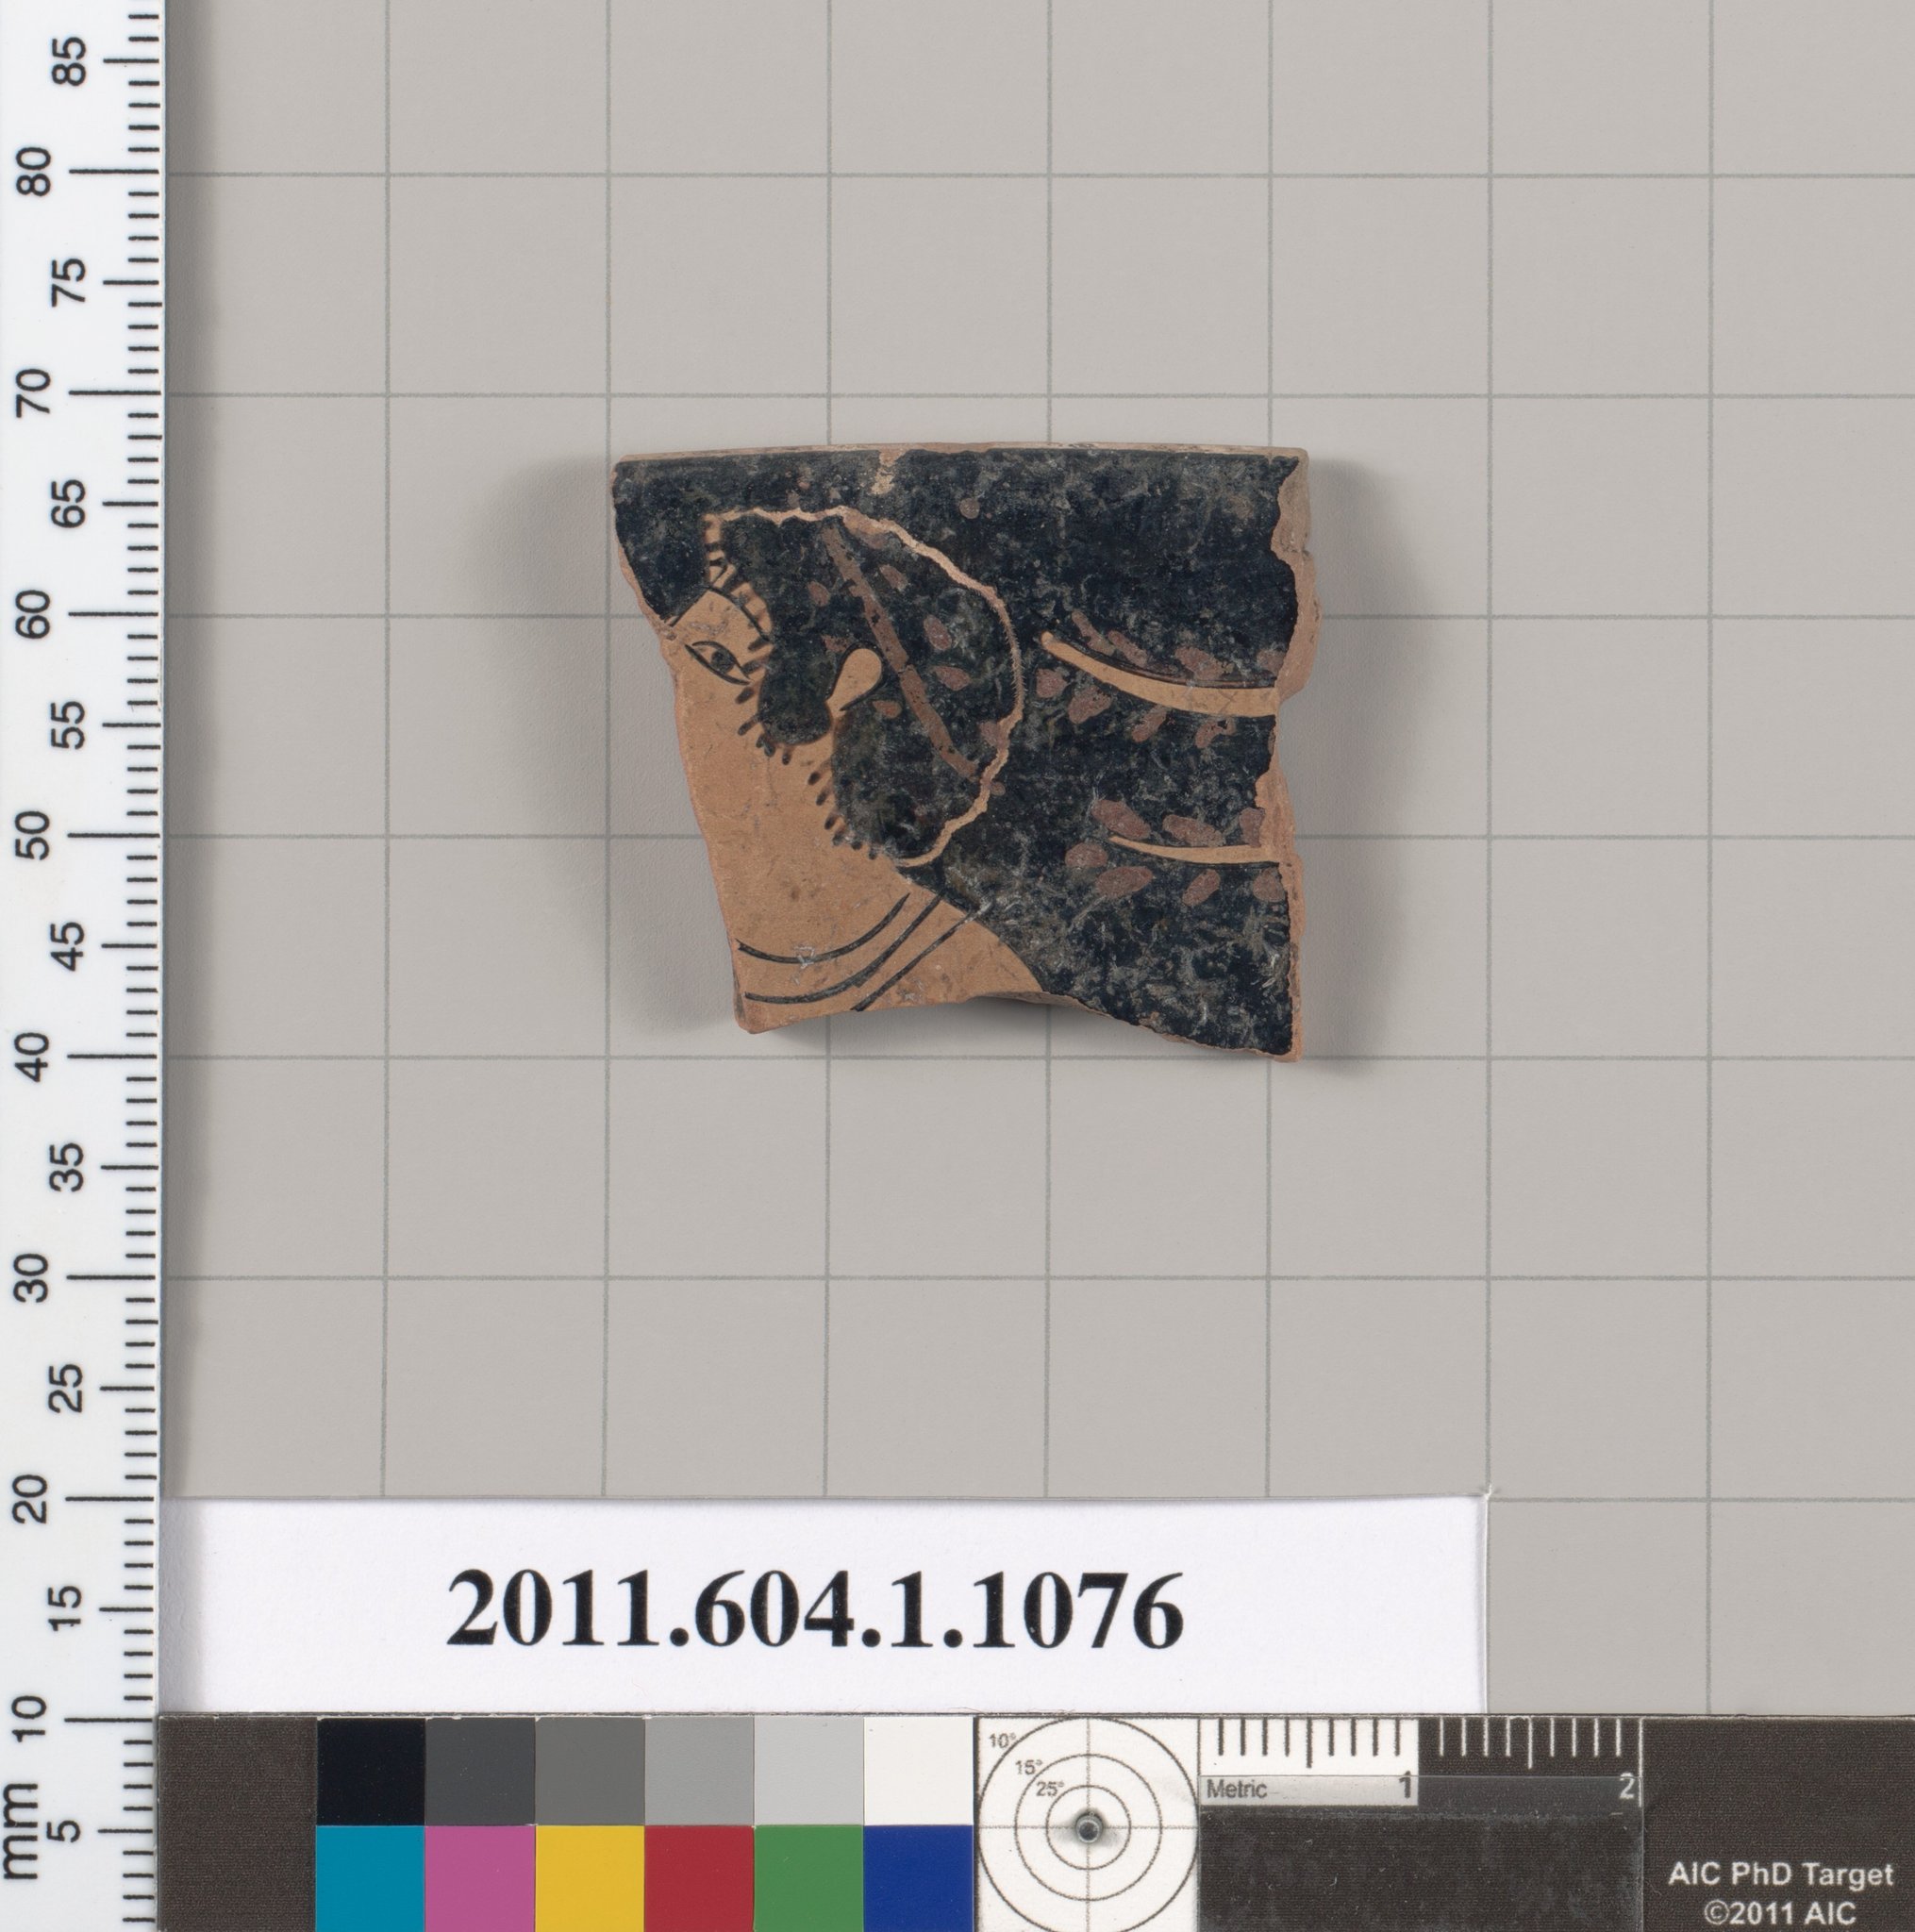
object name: kylix fragment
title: Terracotta rim fragment of a kylix (drinking cup)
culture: greek, attic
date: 510-500 BCE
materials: terracotta